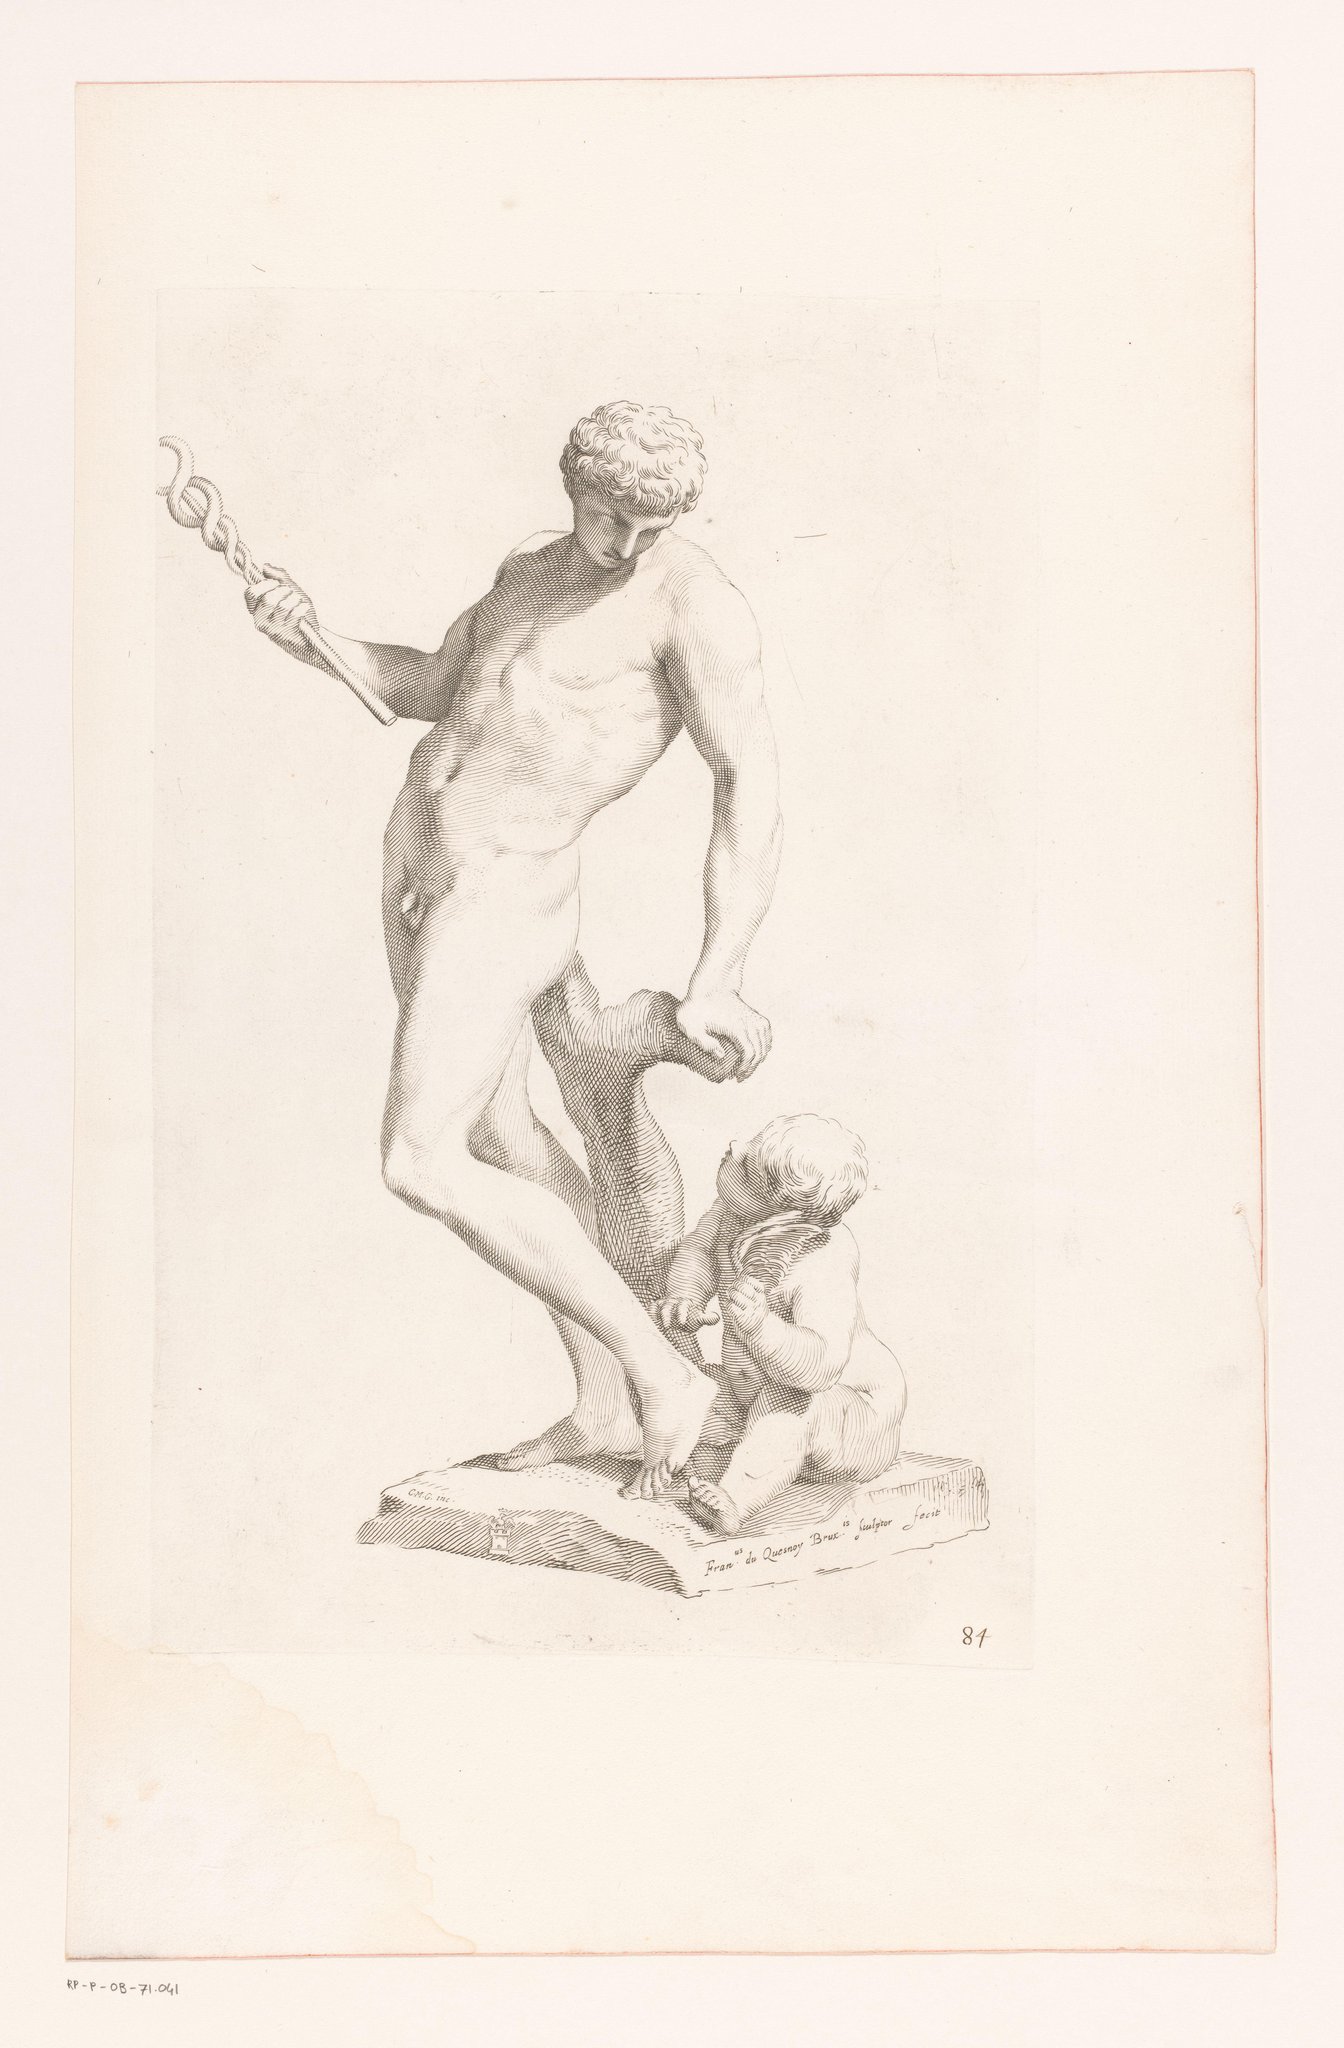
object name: print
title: Galleria Giustiniana del Marchese Vincenzo Giustiniani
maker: françois du quesnoy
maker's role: draughtsman, sculptor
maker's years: 1597-1643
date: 1631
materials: paper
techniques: engraving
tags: rome, vincenzo giustiniani (1564-1637), (story of) mercury (hermes), attributes of mercury: petasus, attributes of mercury: winged sandals, piece of sculpture, reproduction of a piece of sculpture, caduceus (staff with two snakes, attribute of mercury)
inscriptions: collector's mark: Lugt 2228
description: Maakt deel uit van een serie bestaande uit 322 prenten van kunstwerken uit de collectie van Vincenzo Giustiniani die in twee volumes werd uitgegeven door Joachim von Sandrart in 1636 en 1637 (zie British Museum, inv.nr. 1851,1213.565). De serie bestaat uit prenten door verschillende kunstenaars zoals Cornelis Bloemaert, Theodore Matham, Pieter de Bailliu en Michel Natalis. Claude Mellan was verantwoordelijk voor 22 prenten van standbeelden en het 1631 gedateerde portret van Giustiniani.